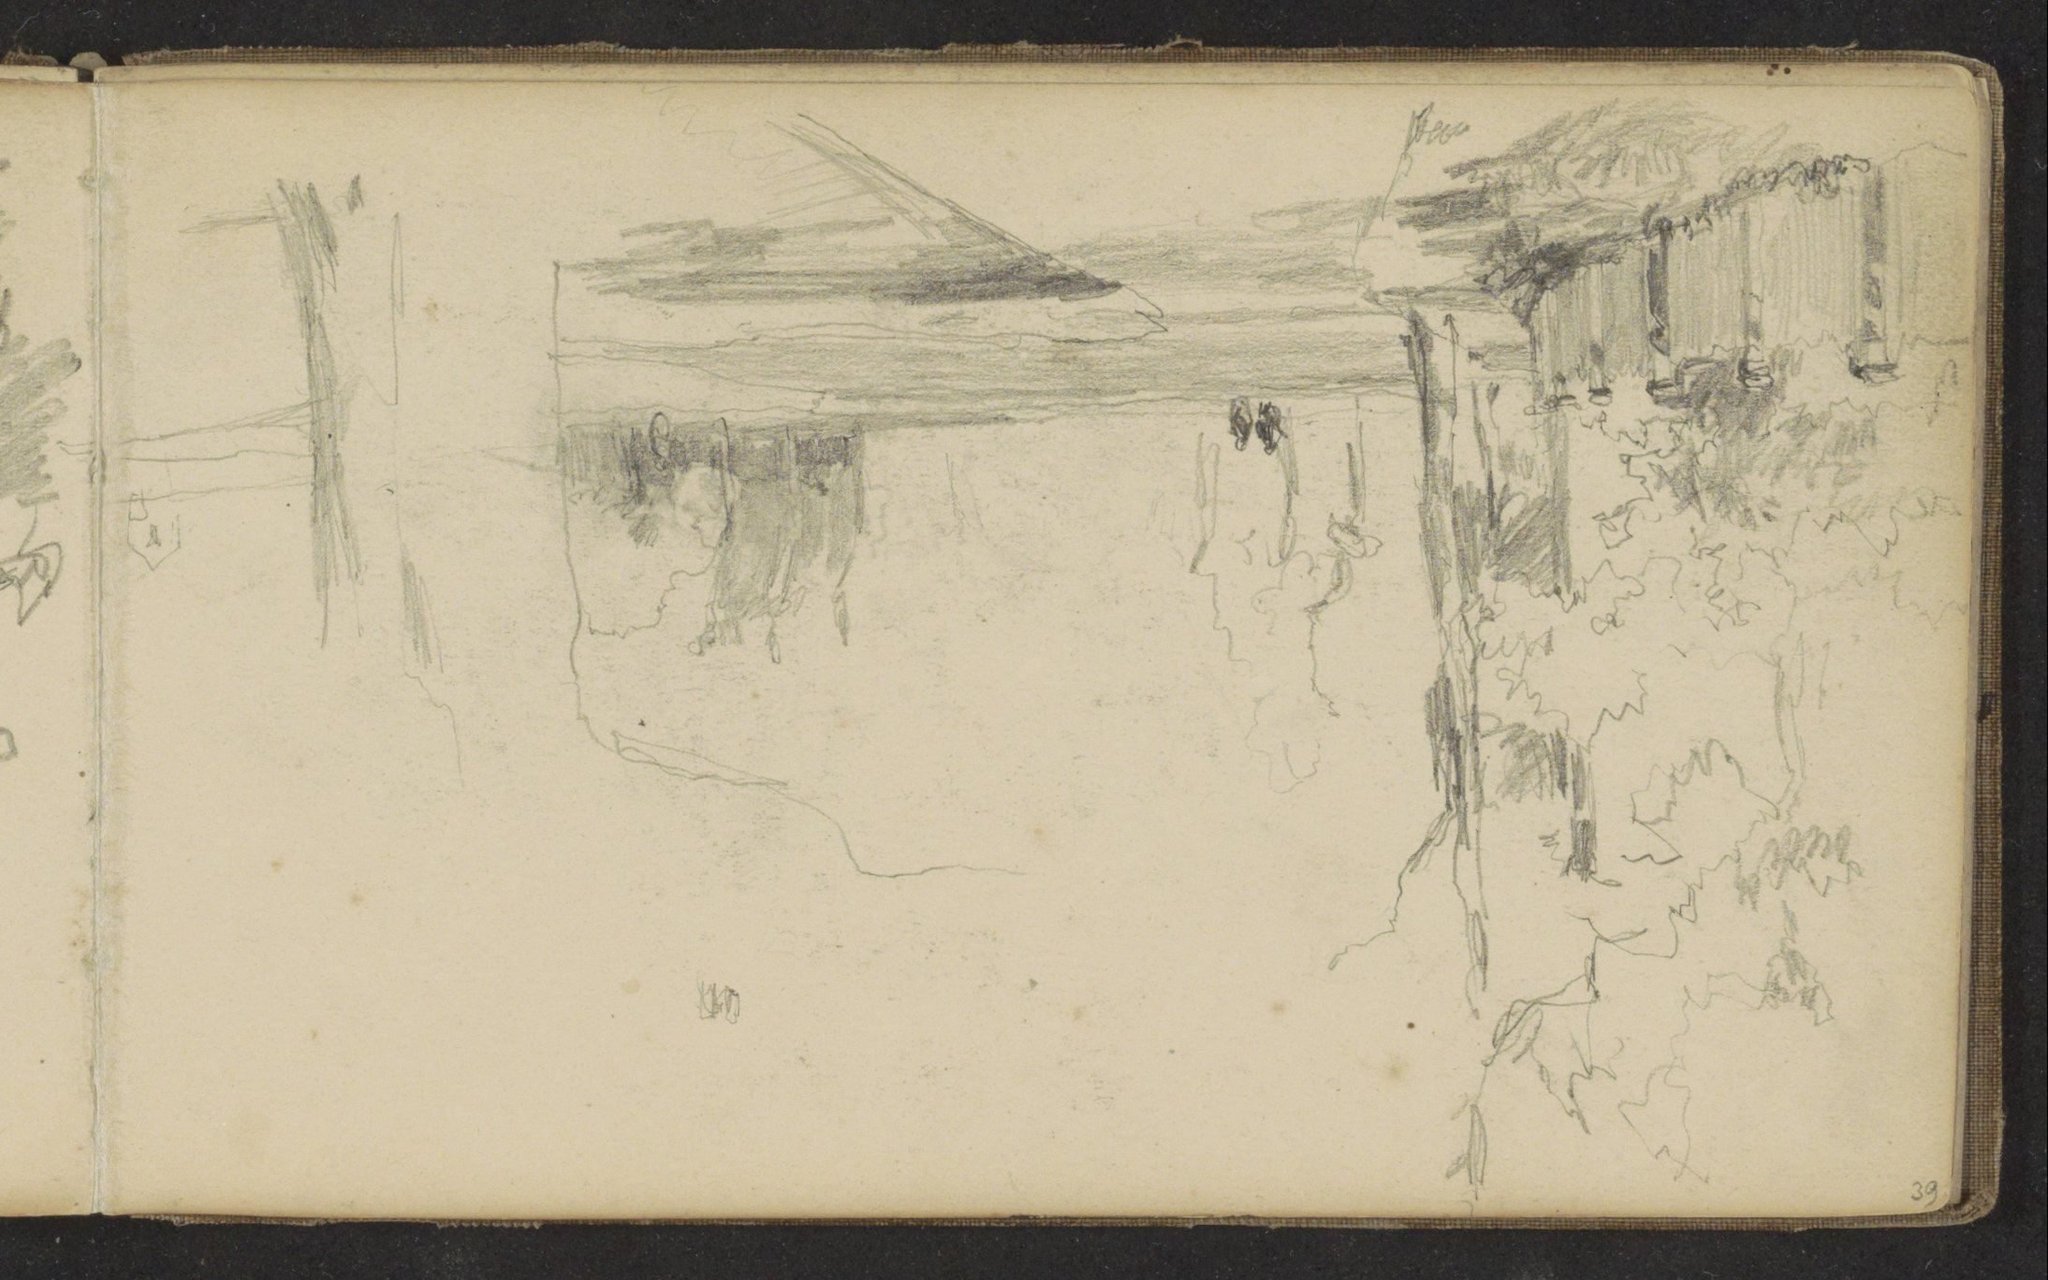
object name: sketchbook leaf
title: Twee figuren op een boomrijke laan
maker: johan hendrik weissenbruch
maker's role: draughtsman, painter, print maker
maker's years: 1824-1903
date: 1834-1903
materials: paper, pencil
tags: trees, fence, wall, paling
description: Blad 39 recto uit een schetsboek met 43 bladen.